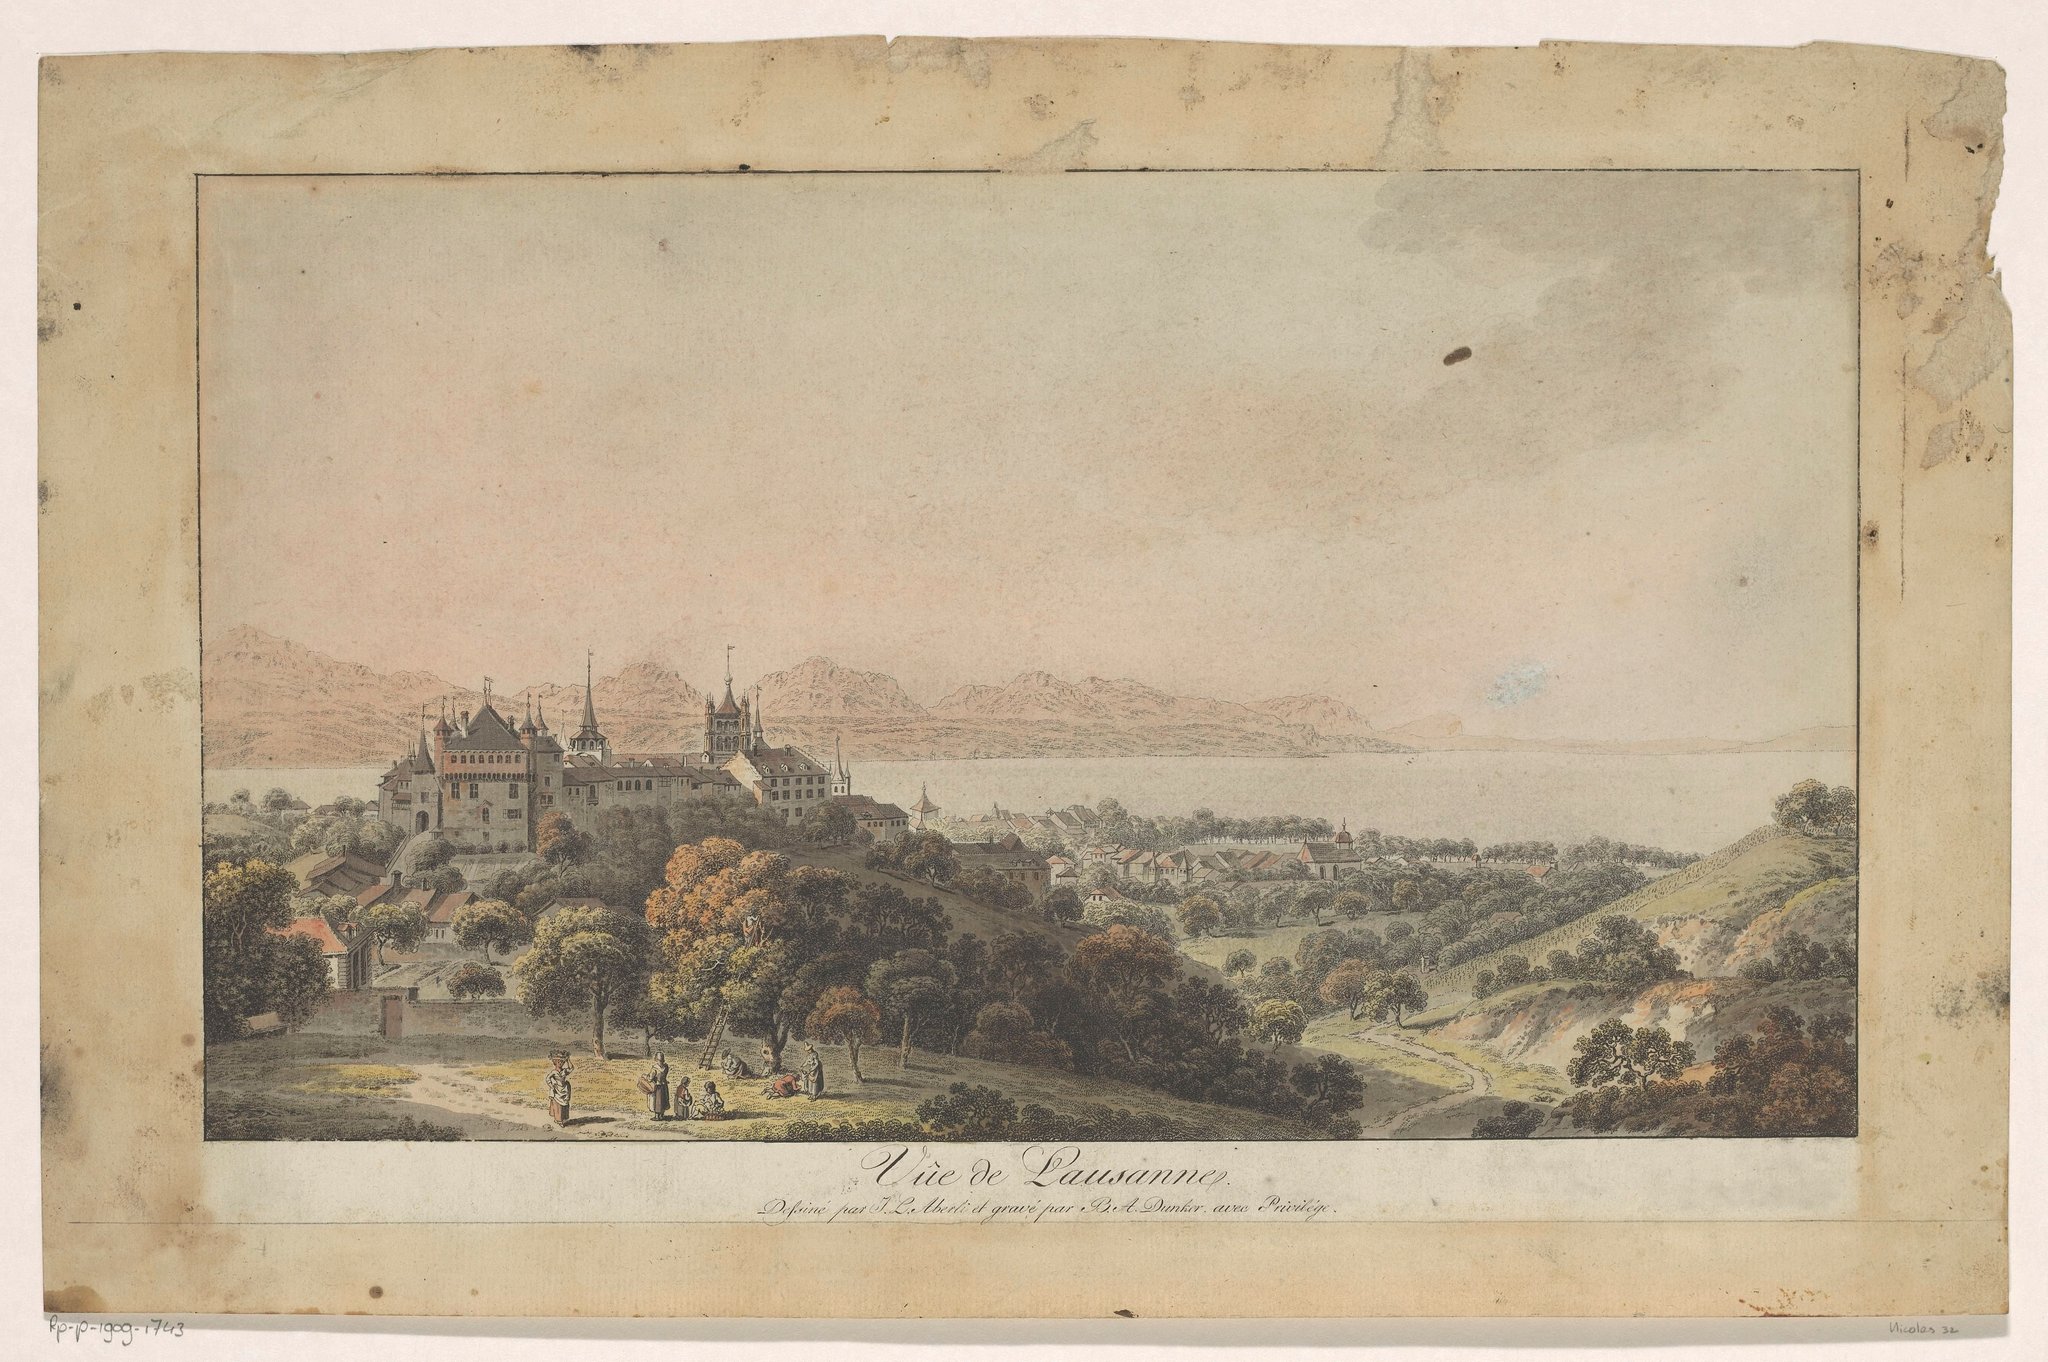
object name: print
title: Gezicht op de Zwitserse stad Lausanne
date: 1756-1807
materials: paper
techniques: etching, hand coloring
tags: city-view, and landscape with man-made constructions, landscapes, picking fruit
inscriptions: collector's mark: Lugt 2228